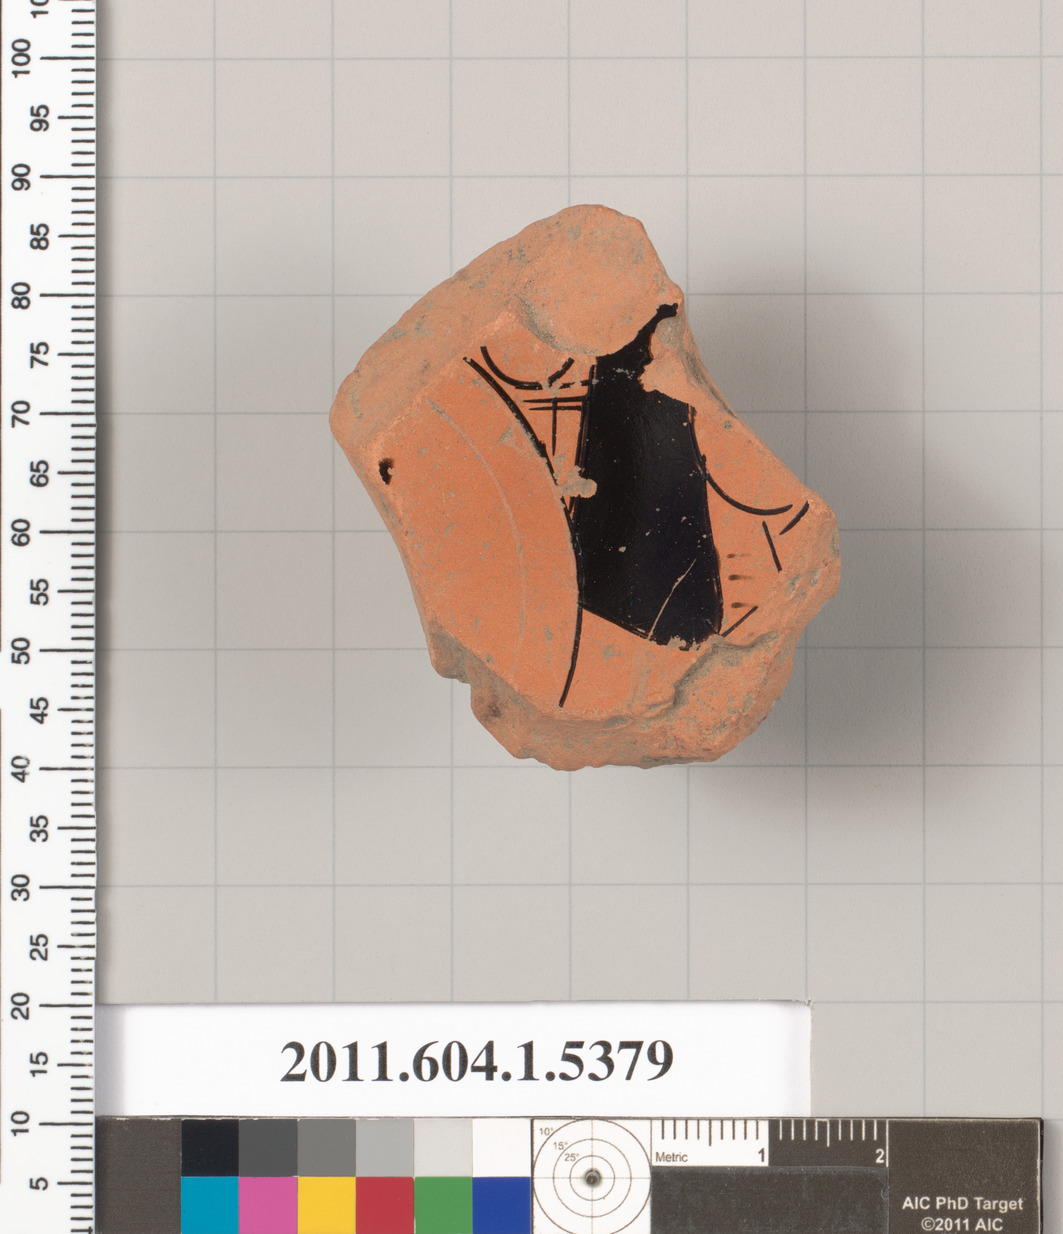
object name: kylix fragment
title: Terracotta fragment of a kylix (drinking cup)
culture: greek, attic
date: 500-490 BCE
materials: terracotta